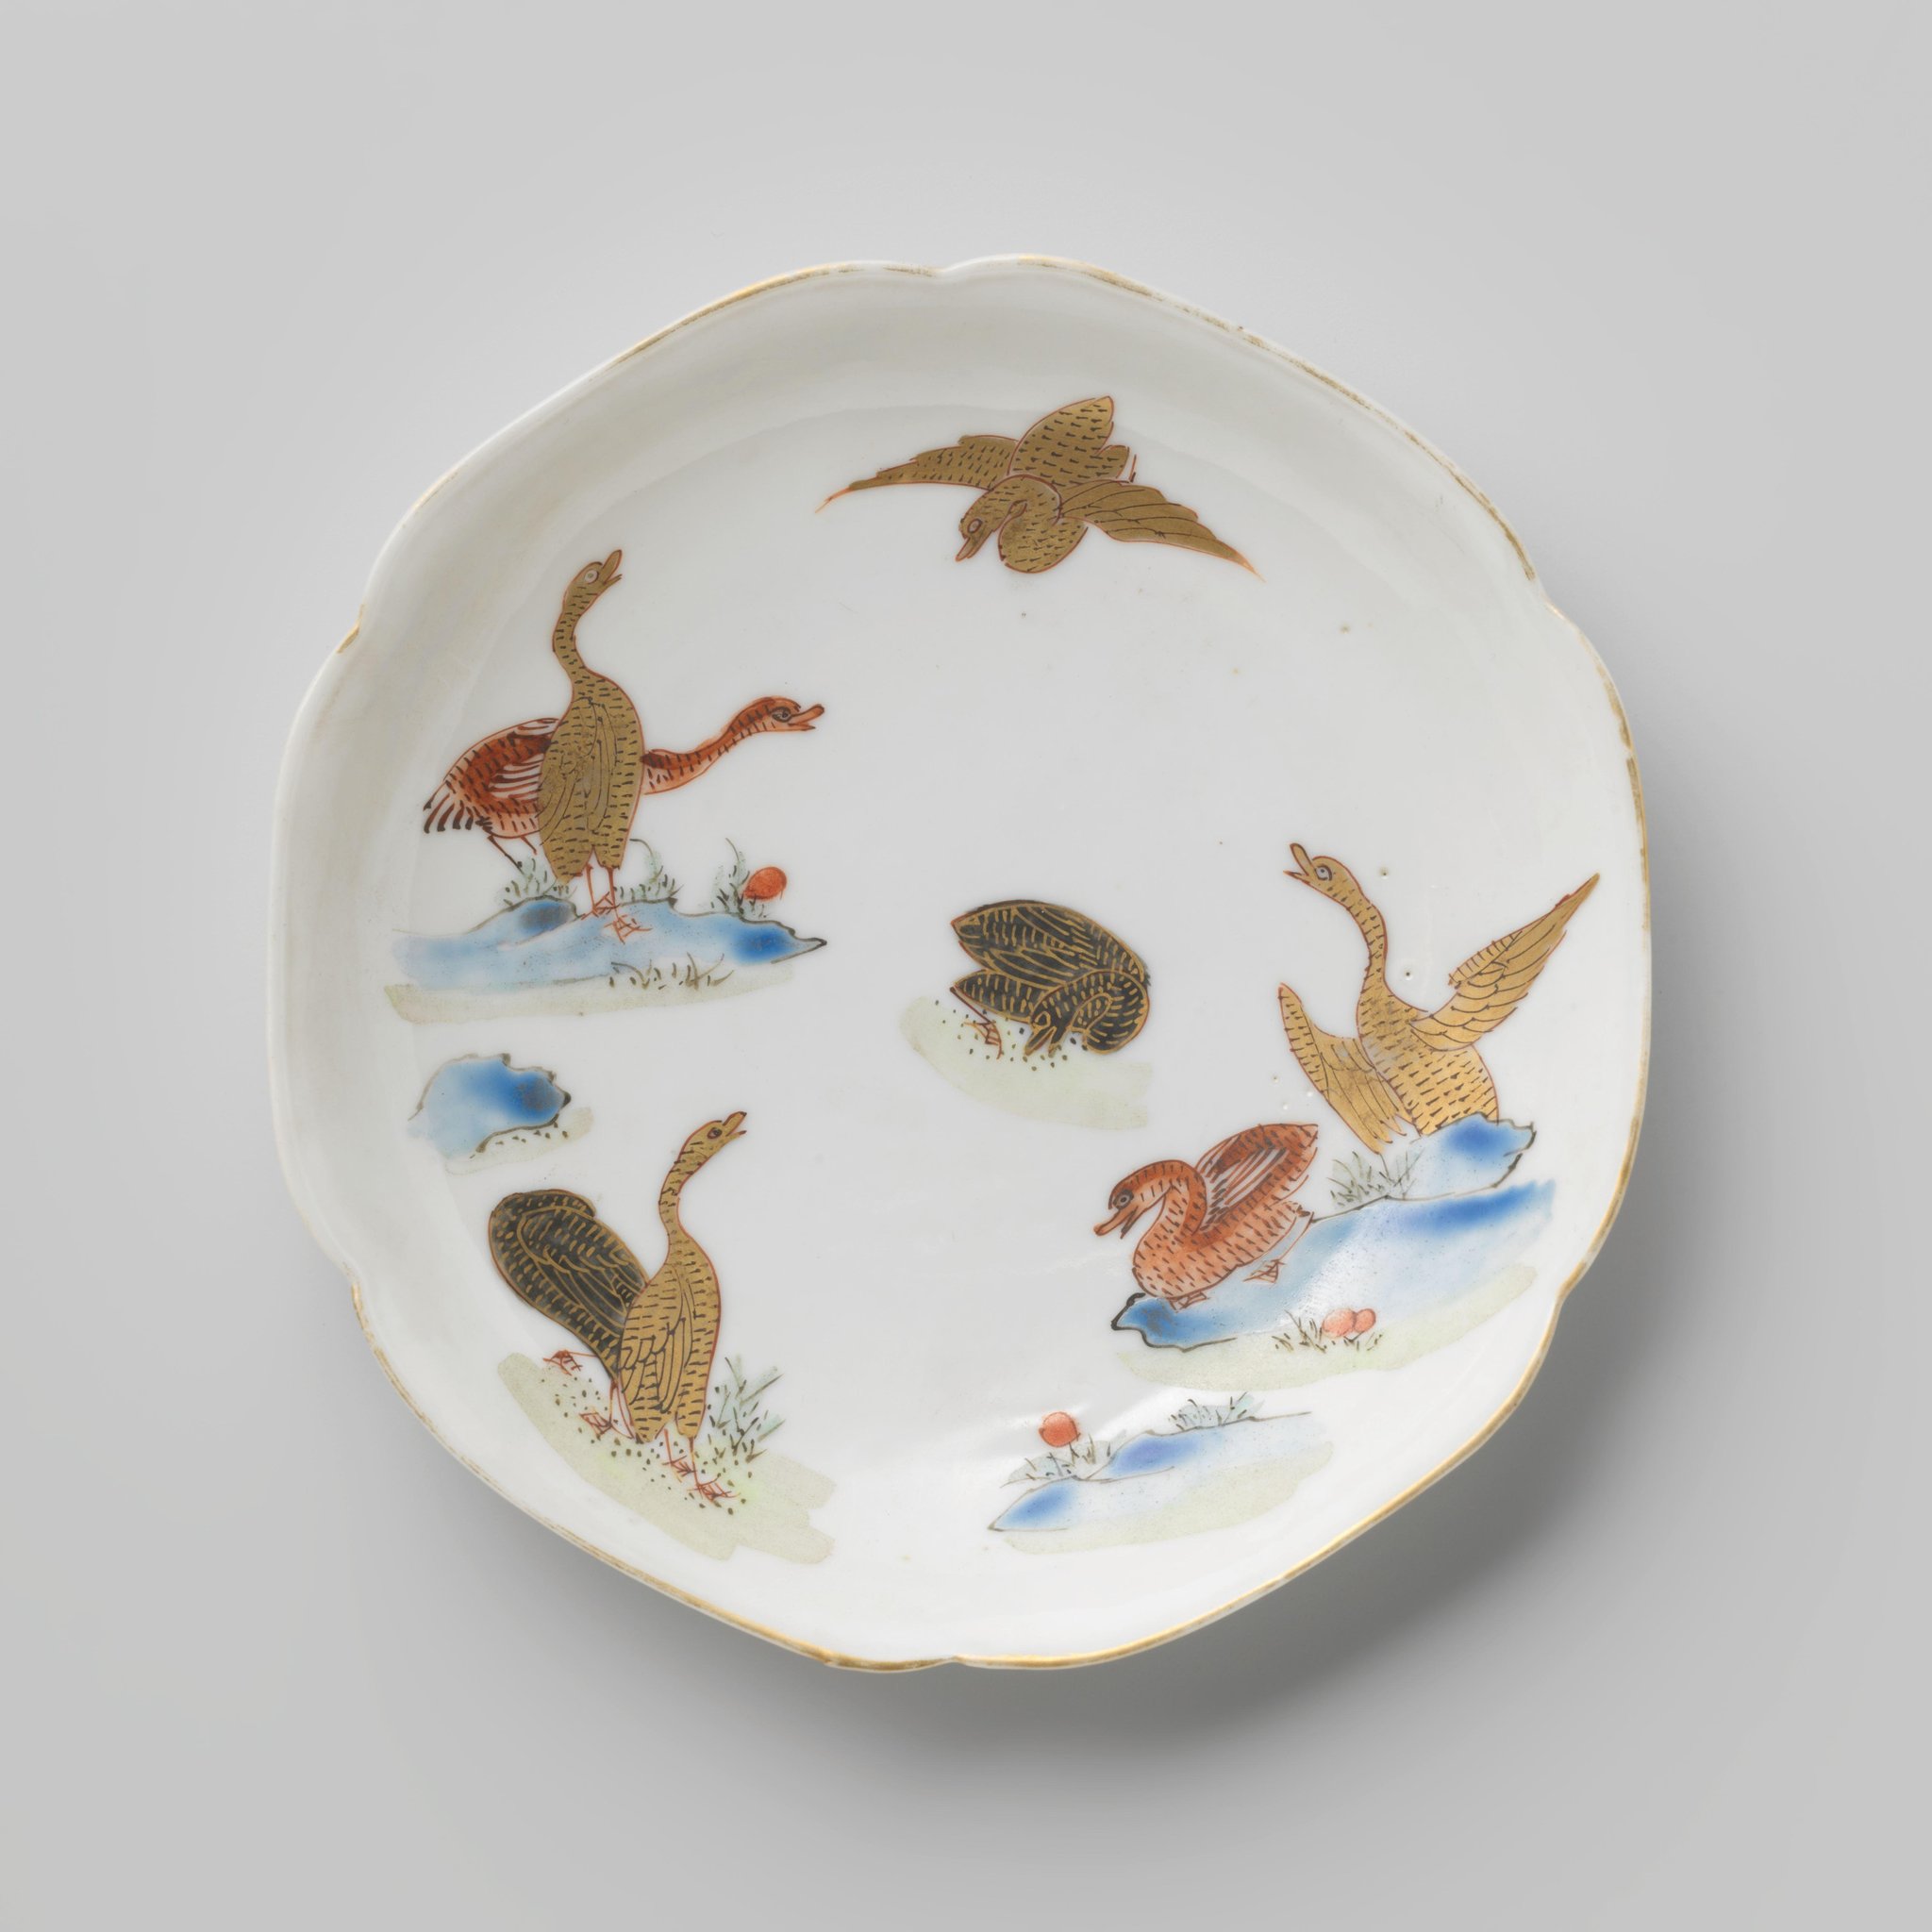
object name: kop en schotel, kop en schotel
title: Saucer with eight geese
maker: Anonymous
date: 1725-1749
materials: glaze, gold, paint, porcelain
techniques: firing, gilding, turning, vitrification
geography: china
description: Schotel met gelobde rand, beschilderd op het glazuur in blauw, rood, groen, zwart en goud. Op de voorzijde van de schotel acht ganzen bij rotsen, grazend of vliegend. Porselein met emailkleuren.